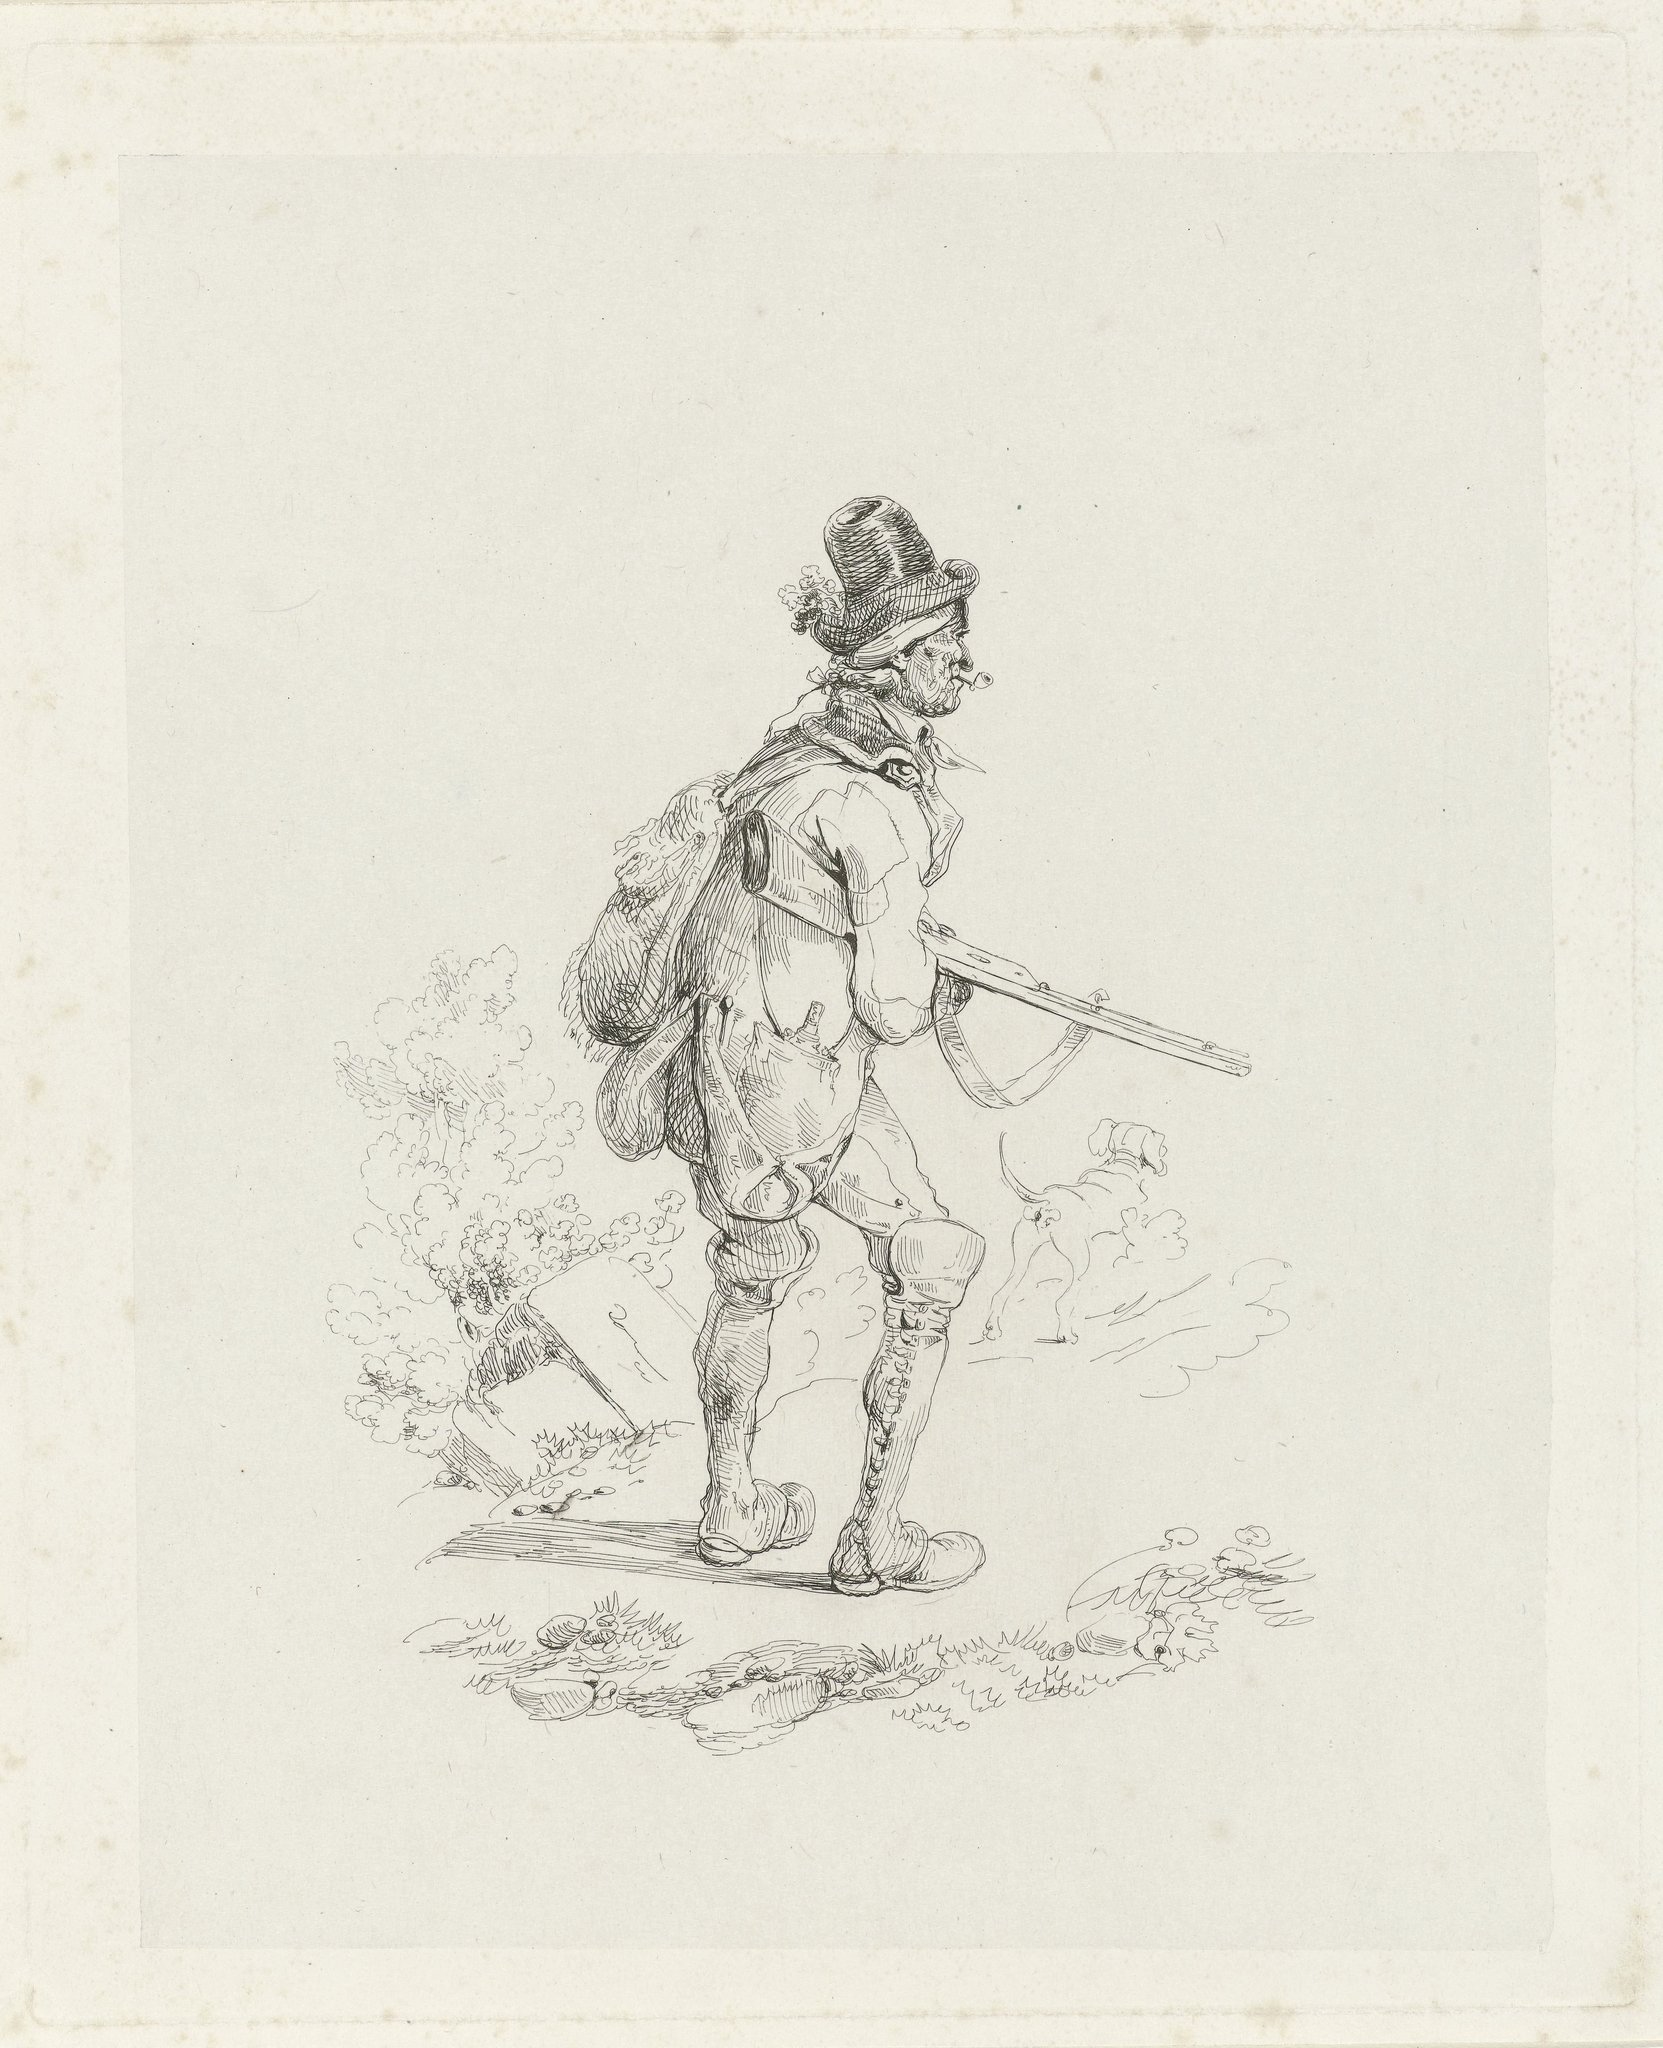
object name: print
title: Jager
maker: gaspard louis françois van kinschot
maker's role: print maker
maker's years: 1811-1861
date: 1821-1861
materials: paper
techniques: etching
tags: hunting dogs, hunter, pipe ~ tobacco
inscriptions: collector's mark: Lugt 2228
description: In een landschap loopt een jager achter zijn hond aan, naar rechts. Hij rookt een pijp en houdt zijn geweer onder zijn rechterarm.